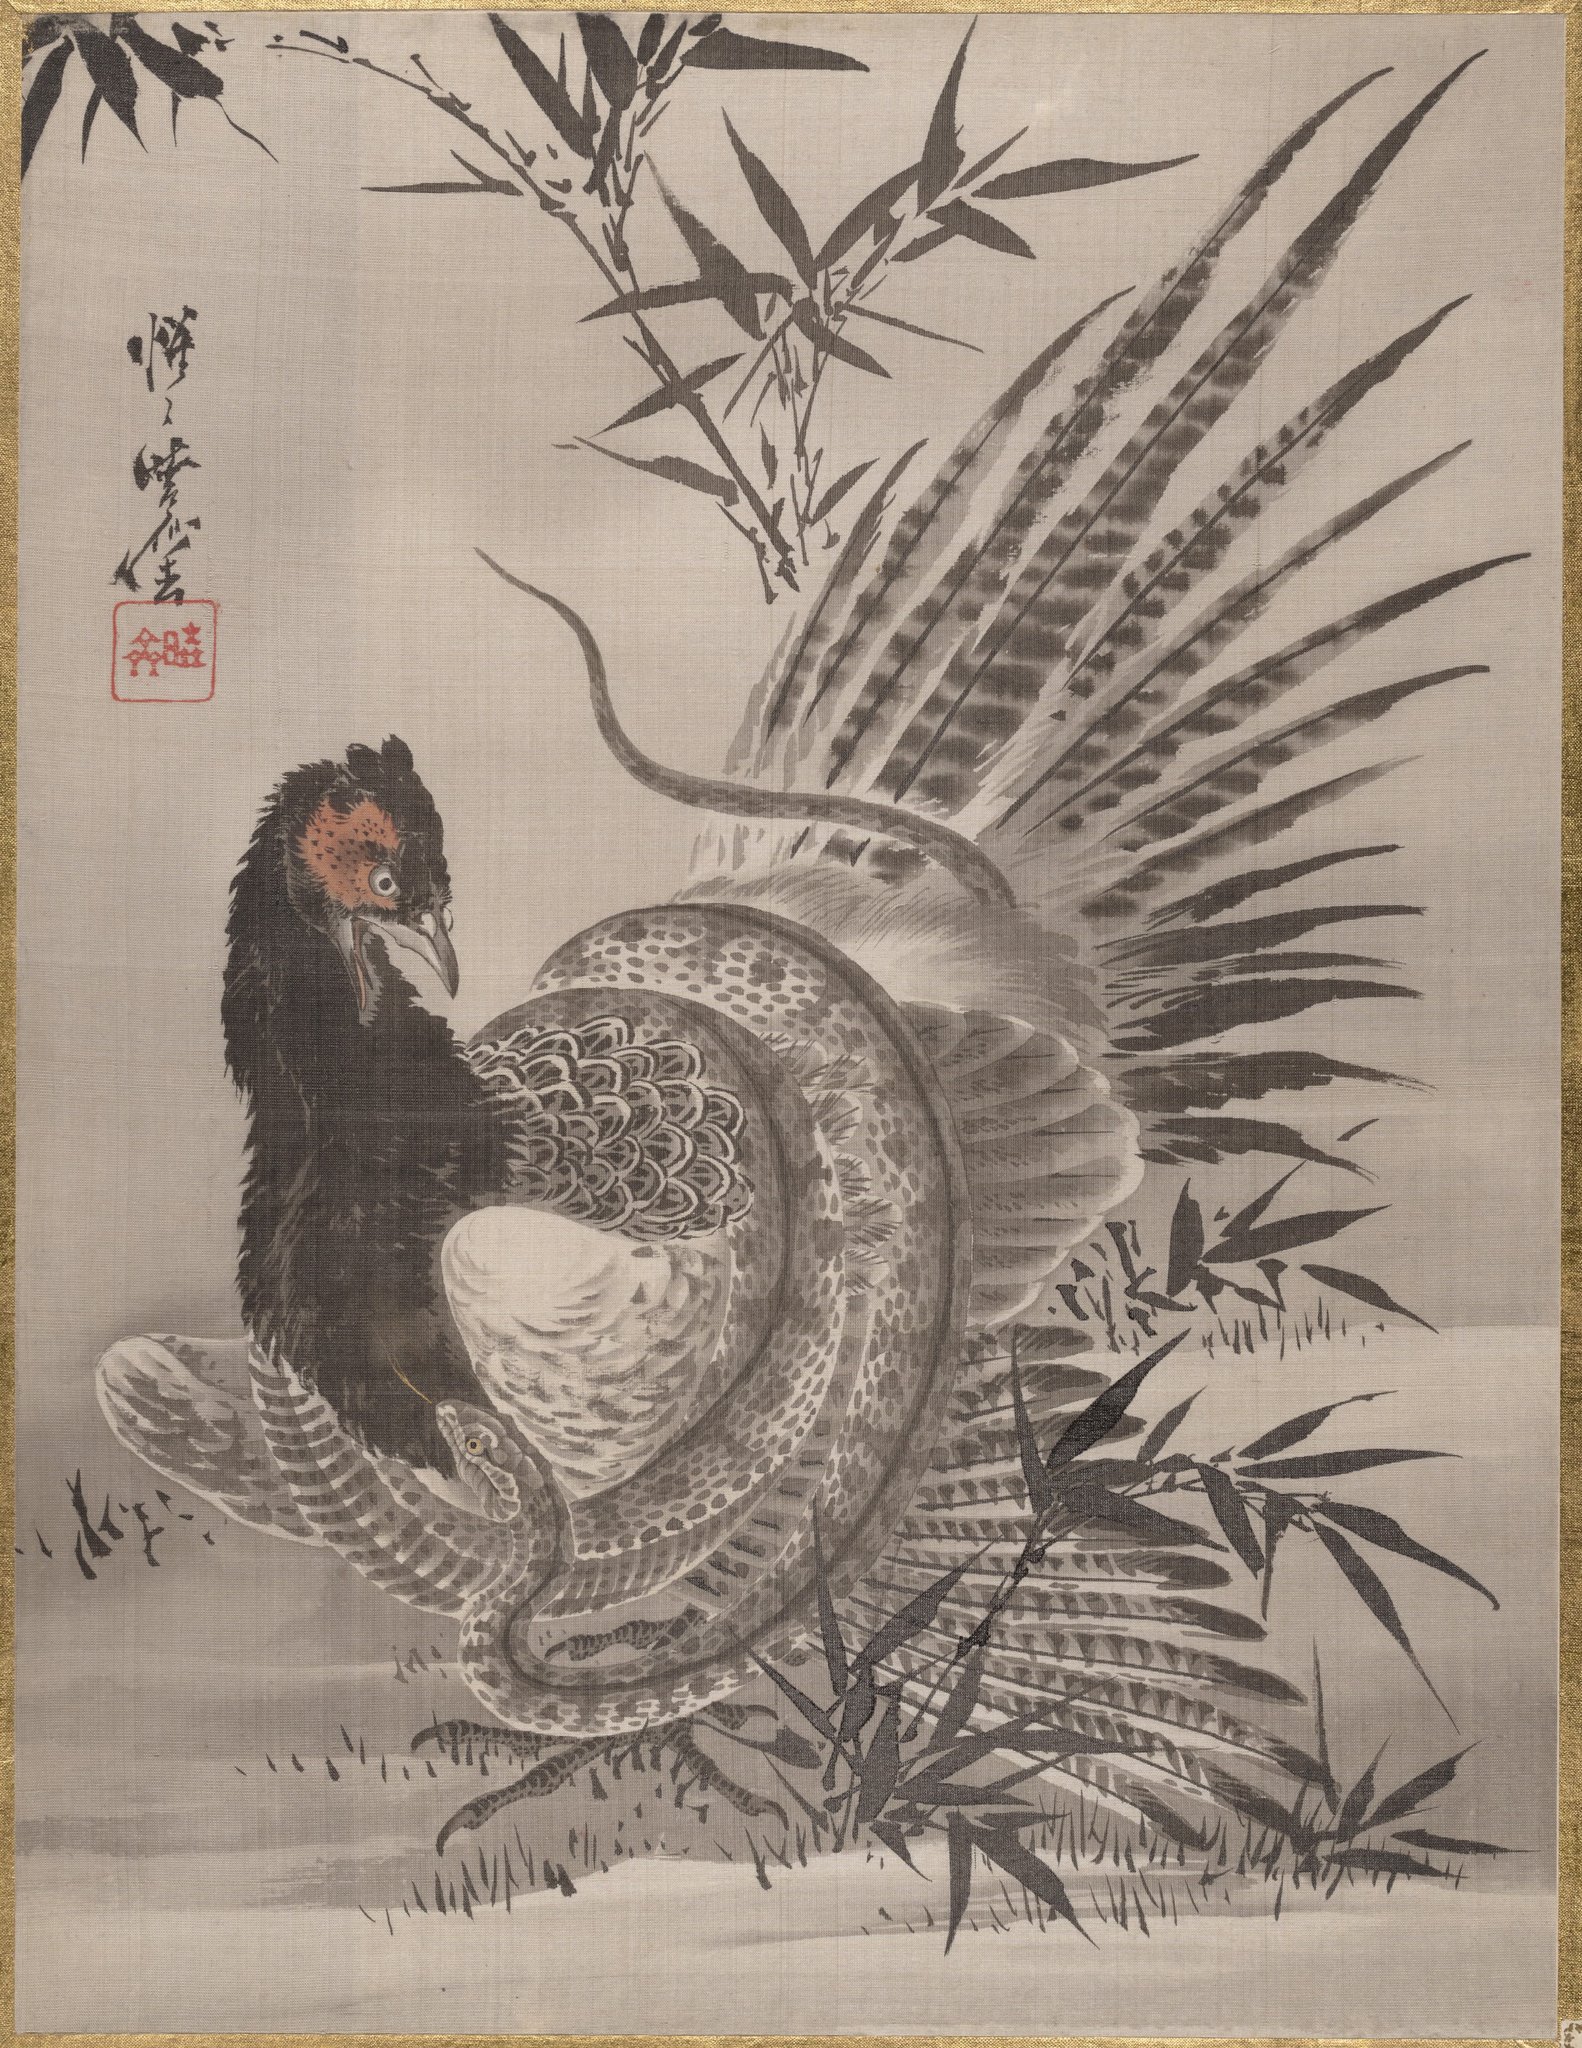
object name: album leaf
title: Pheasant Caught by a Snake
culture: japanese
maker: kawanabe kyōsai 河鍋暁斎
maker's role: artist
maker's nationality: japanese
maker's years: 1831-1889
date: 1887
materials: ink, silk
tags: pheasants,snakes